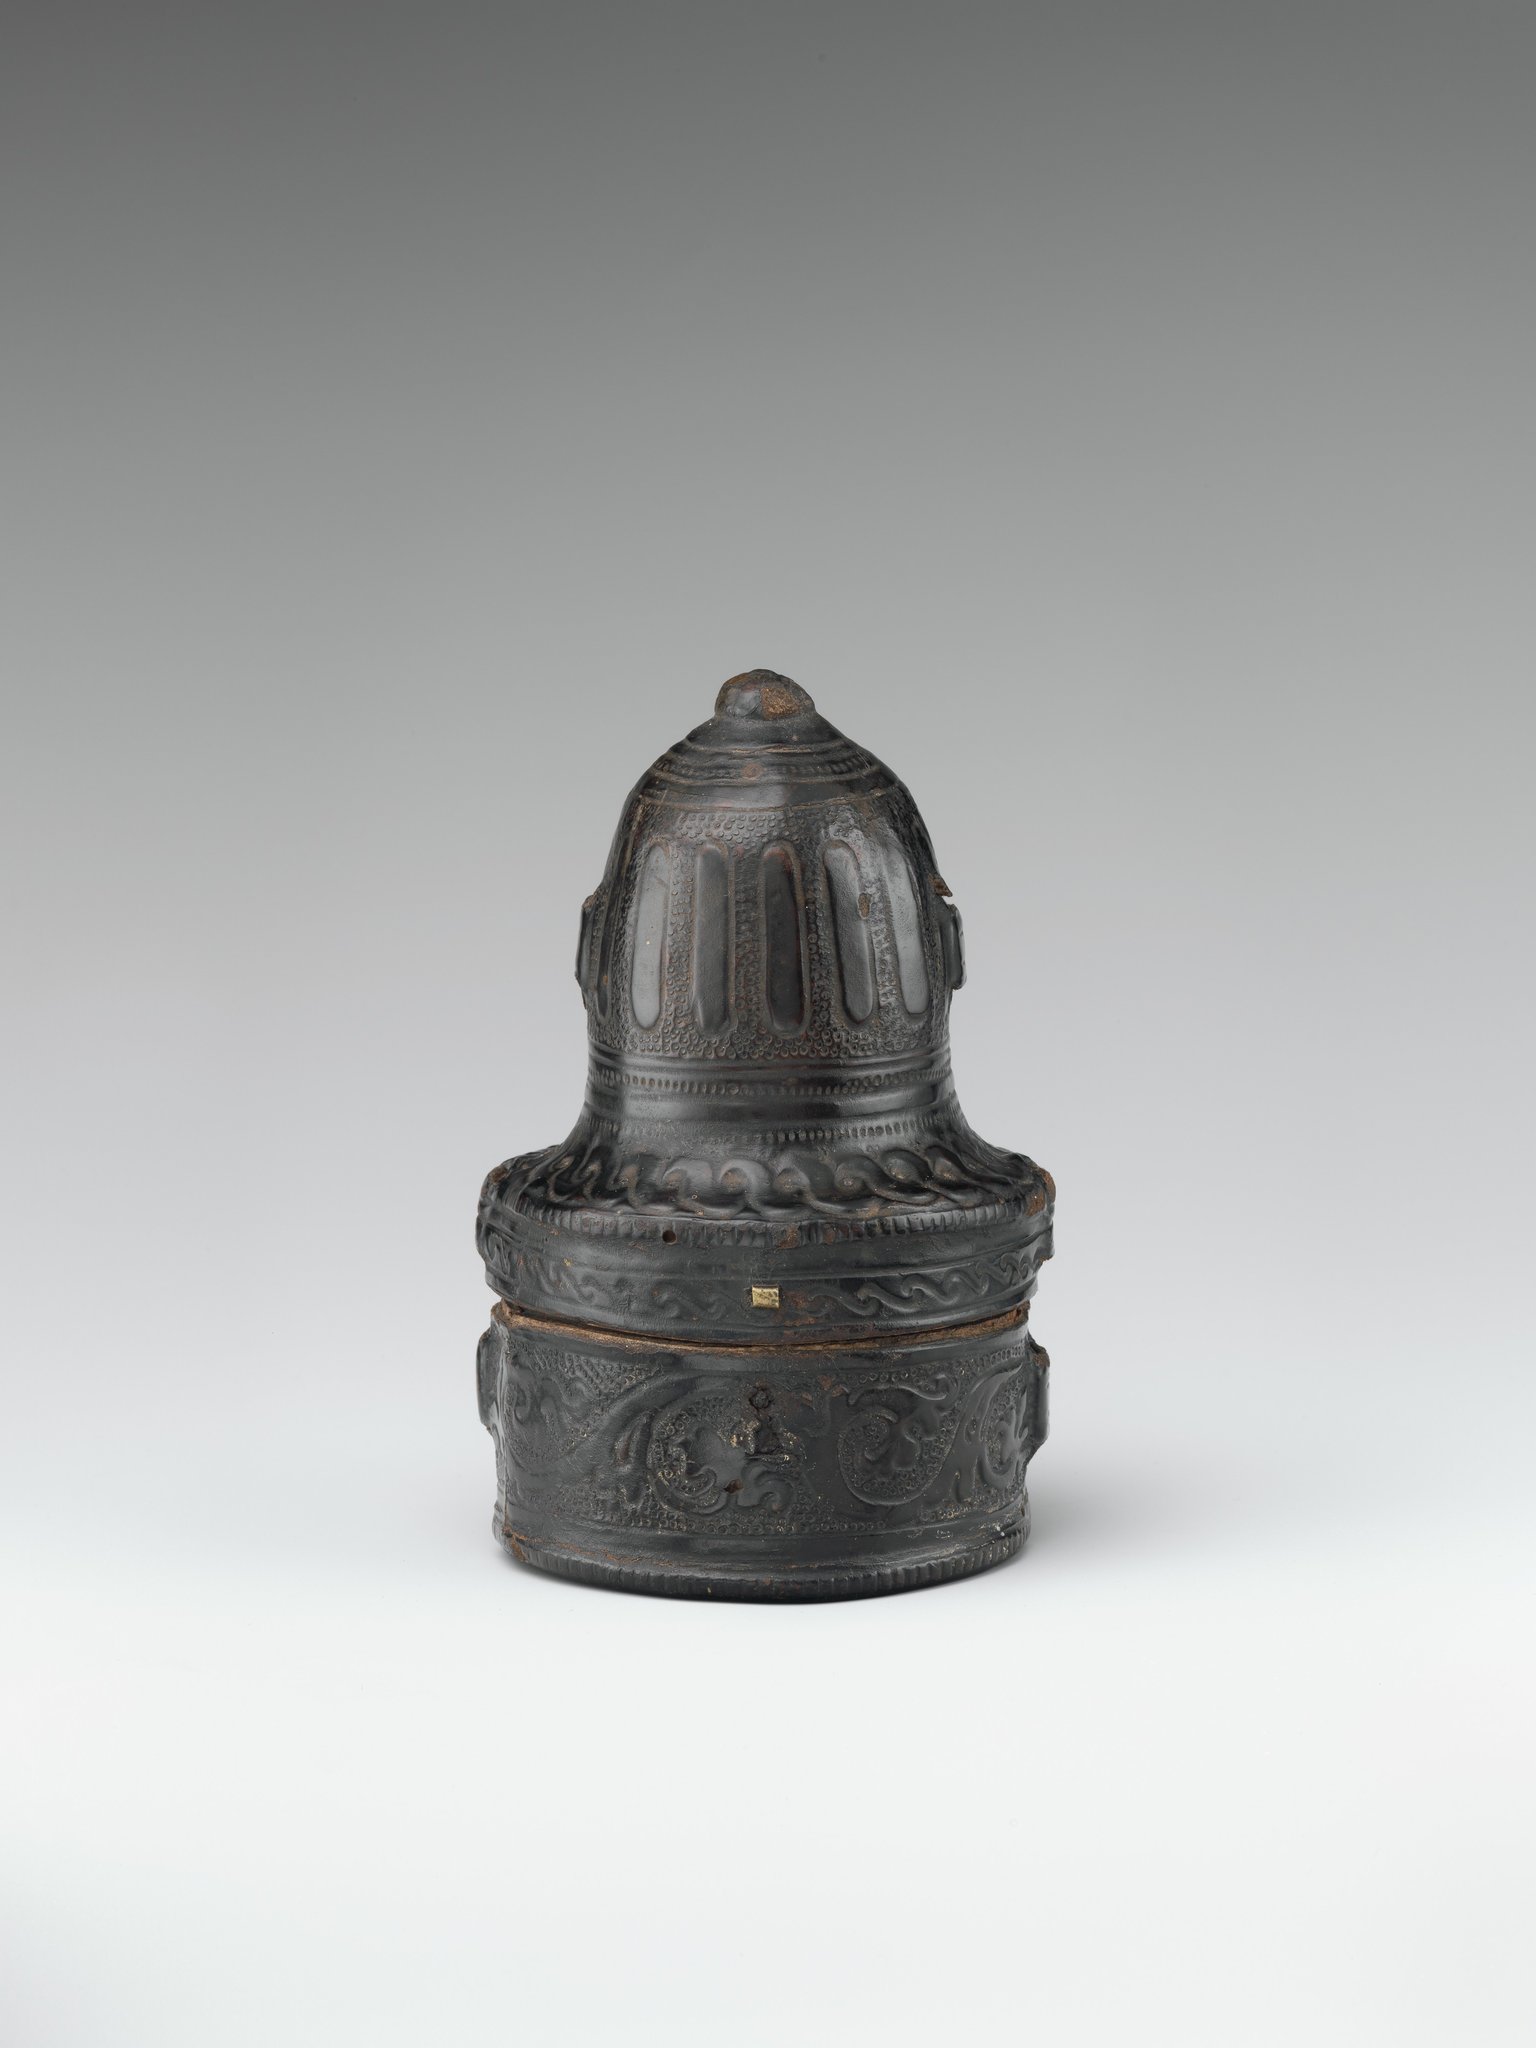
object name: alarm case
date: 1567-1600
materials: leather, wood